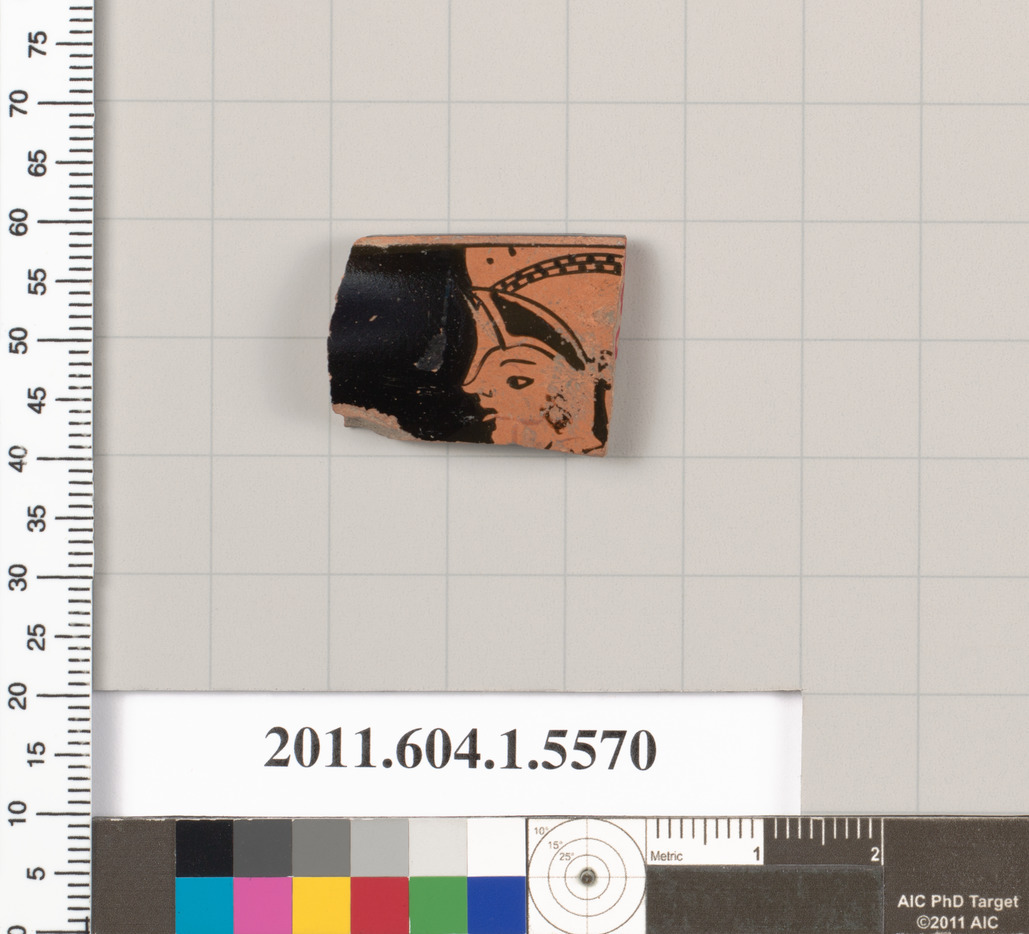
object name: kylix fragment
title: Terracotta rim fragment of a kylix (drinking cup)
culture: greek, attic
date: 475-451 BCE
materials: terracotta